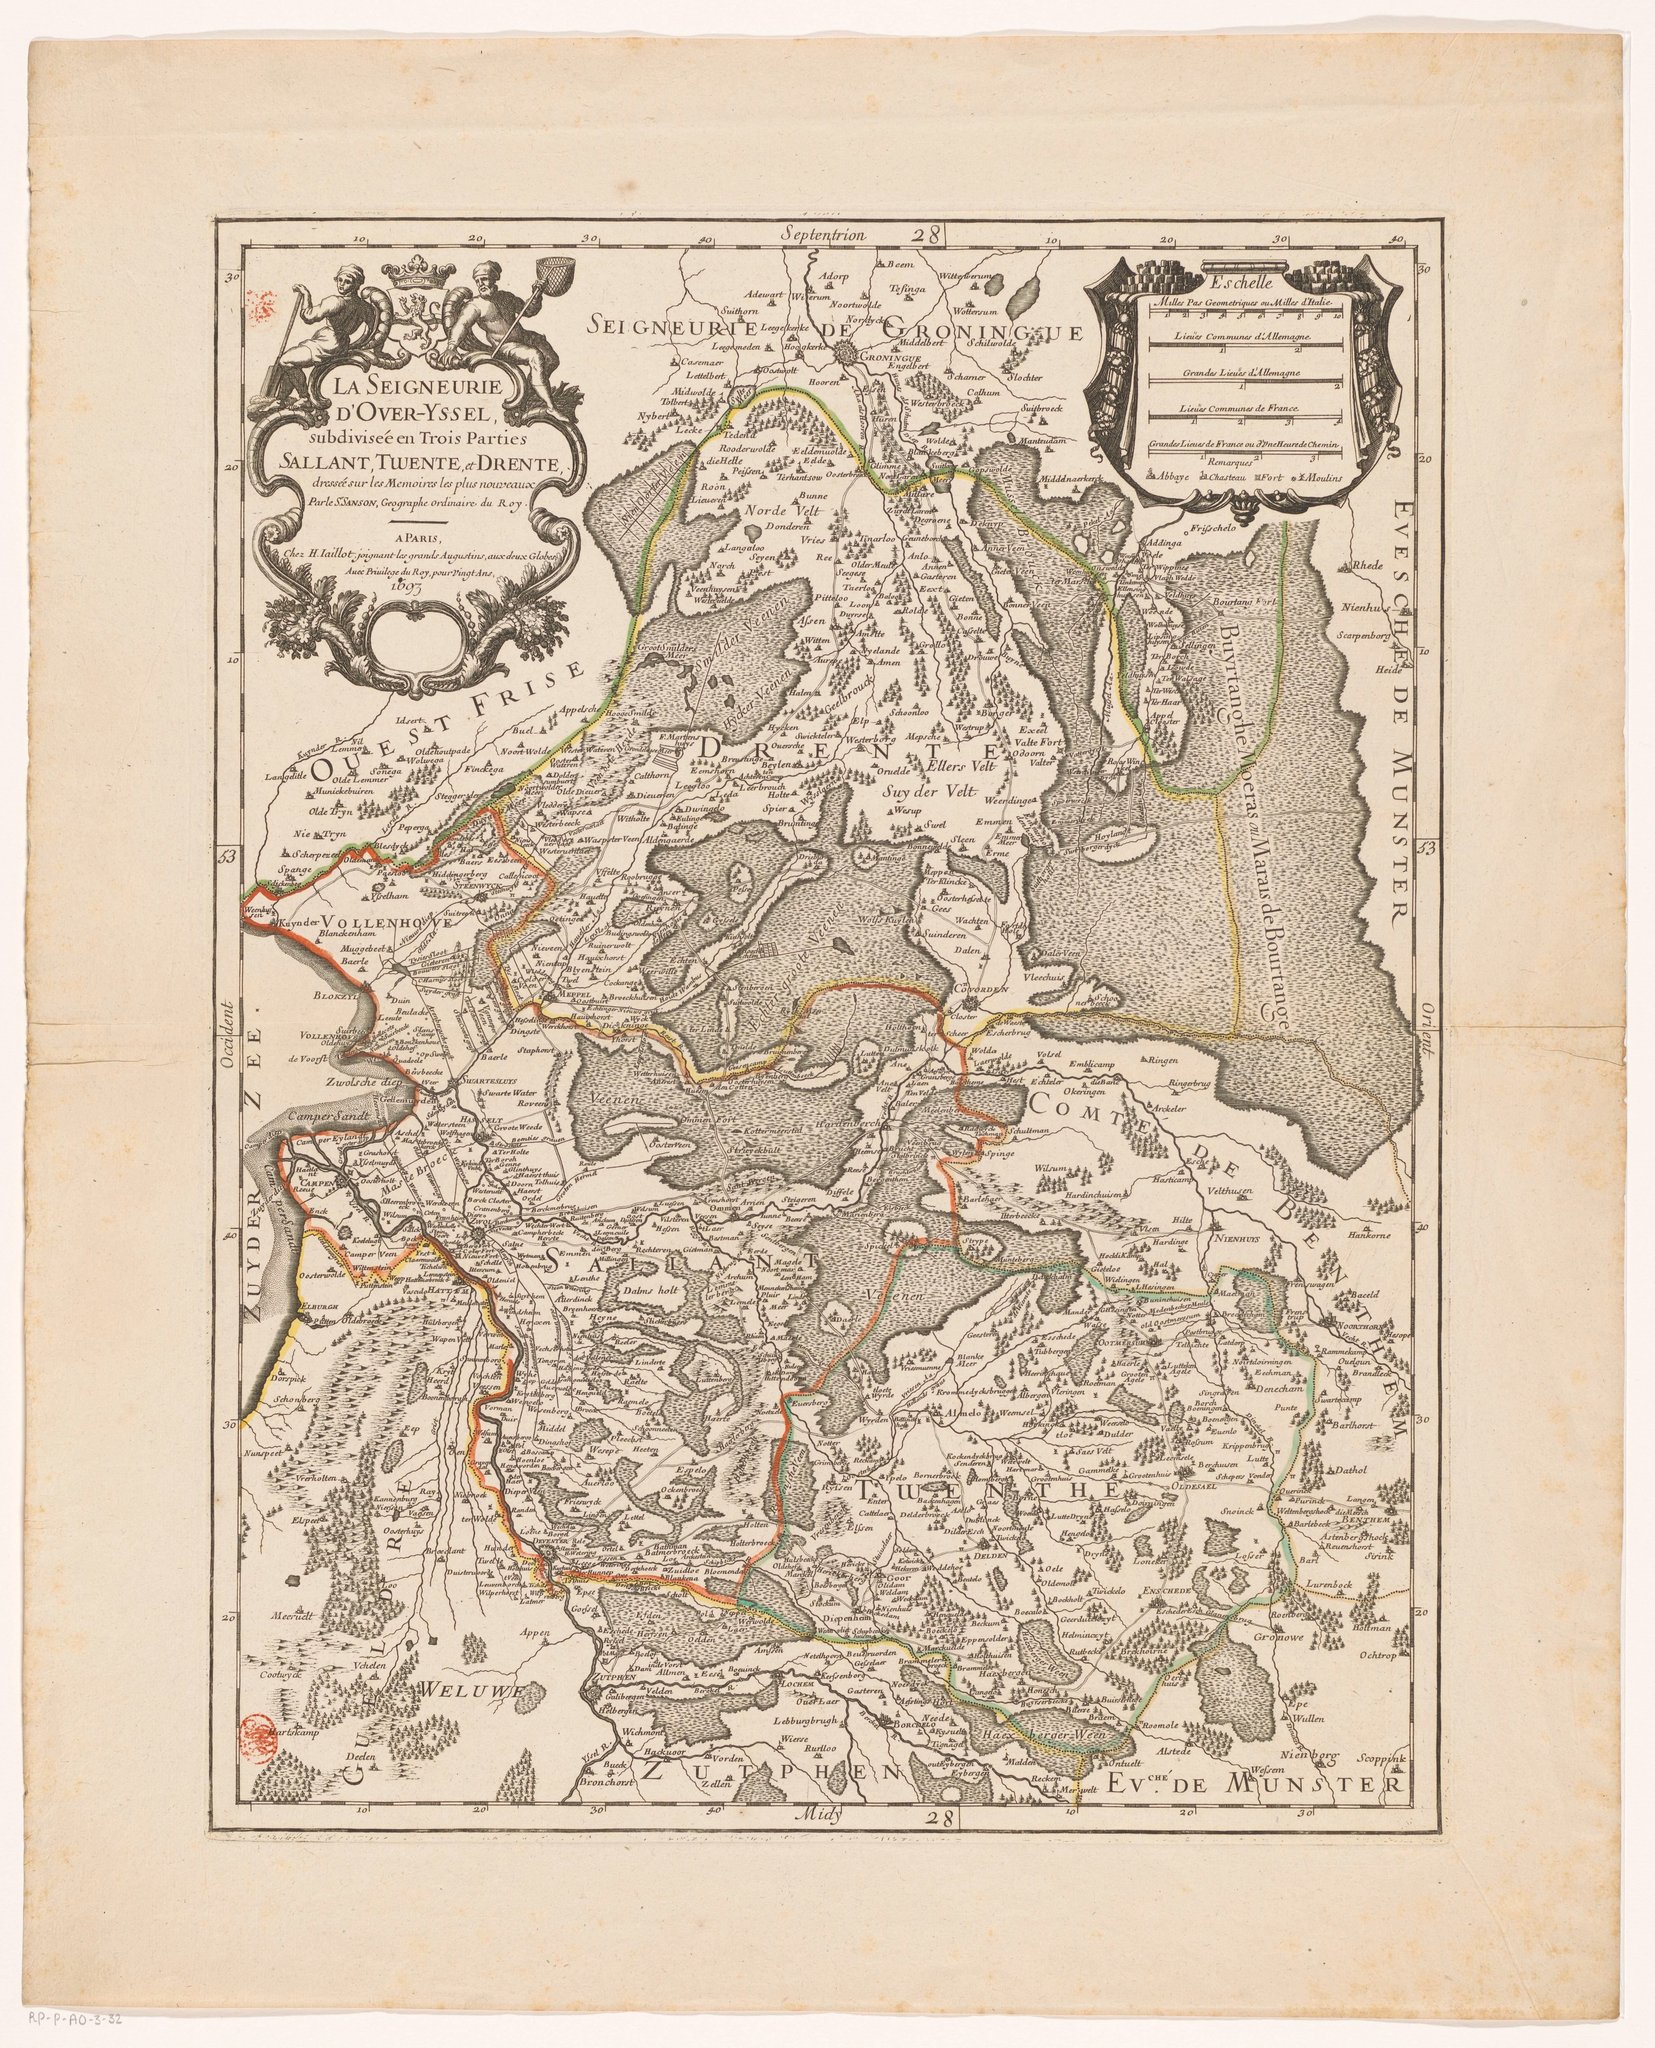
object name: map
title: La seigneurie d'Over-yssel subdivisée en trois parties Sallant, Twente, et Drente (...)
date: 1693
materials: paper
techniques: engraving, hand coloring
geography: paris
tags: coat of arms (as symbol of the state, etc.), peat-cutting, maps of separate countries or regions, fisherman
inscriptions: collector's mark: Lugt 195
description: Linksboven cartouche met titel, het wapen van Overijssel, een visser en een turfsteker. Rechtsboven legenda en vijf schaalstokken: Milles pas geometriques ou milles d'Italie, Lieües communes d'Allemagne en nog drie andere. Gradenverdeling langs de randen.